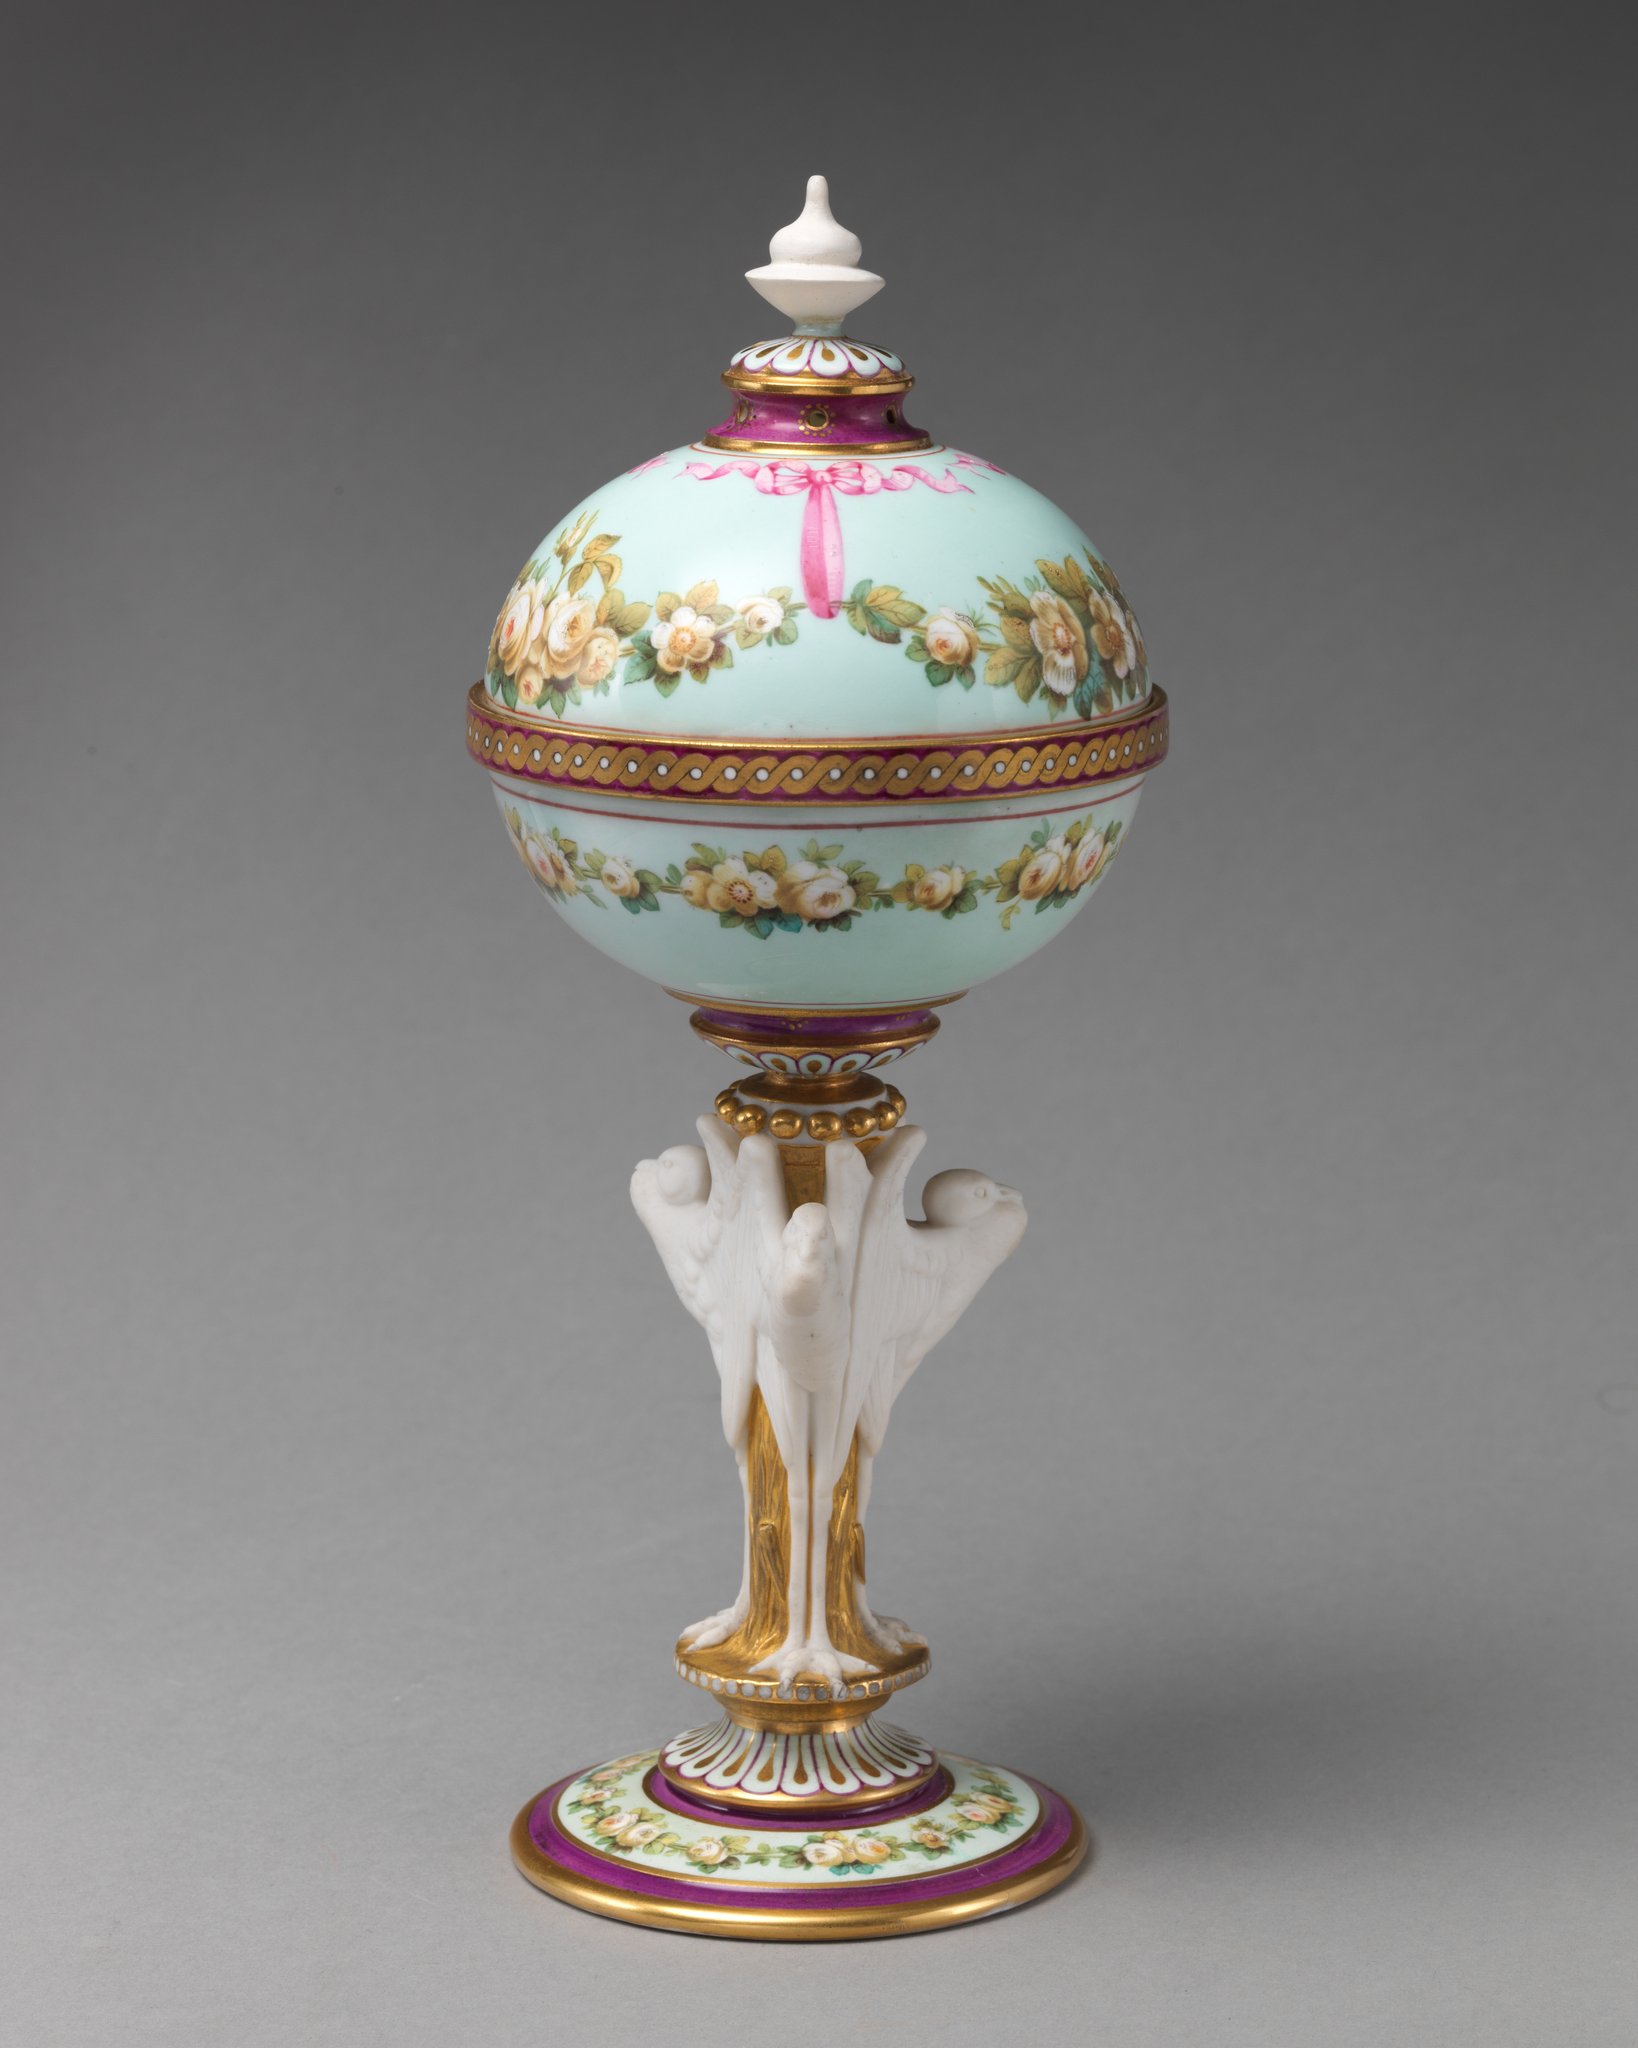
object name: potpourri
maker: minton(s)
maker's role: maker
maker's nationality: british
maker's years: 1793-2001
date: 1860-1870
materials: bone china, porcelain